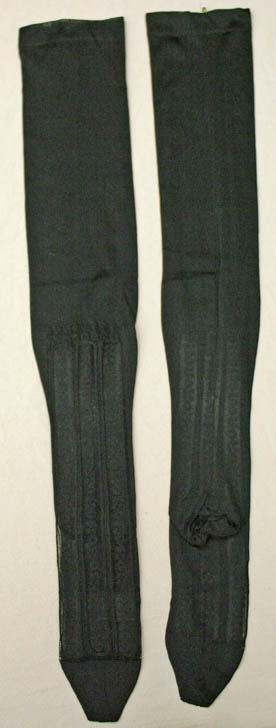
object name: stocking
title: Stockings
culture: french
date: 1801-1900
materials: silk